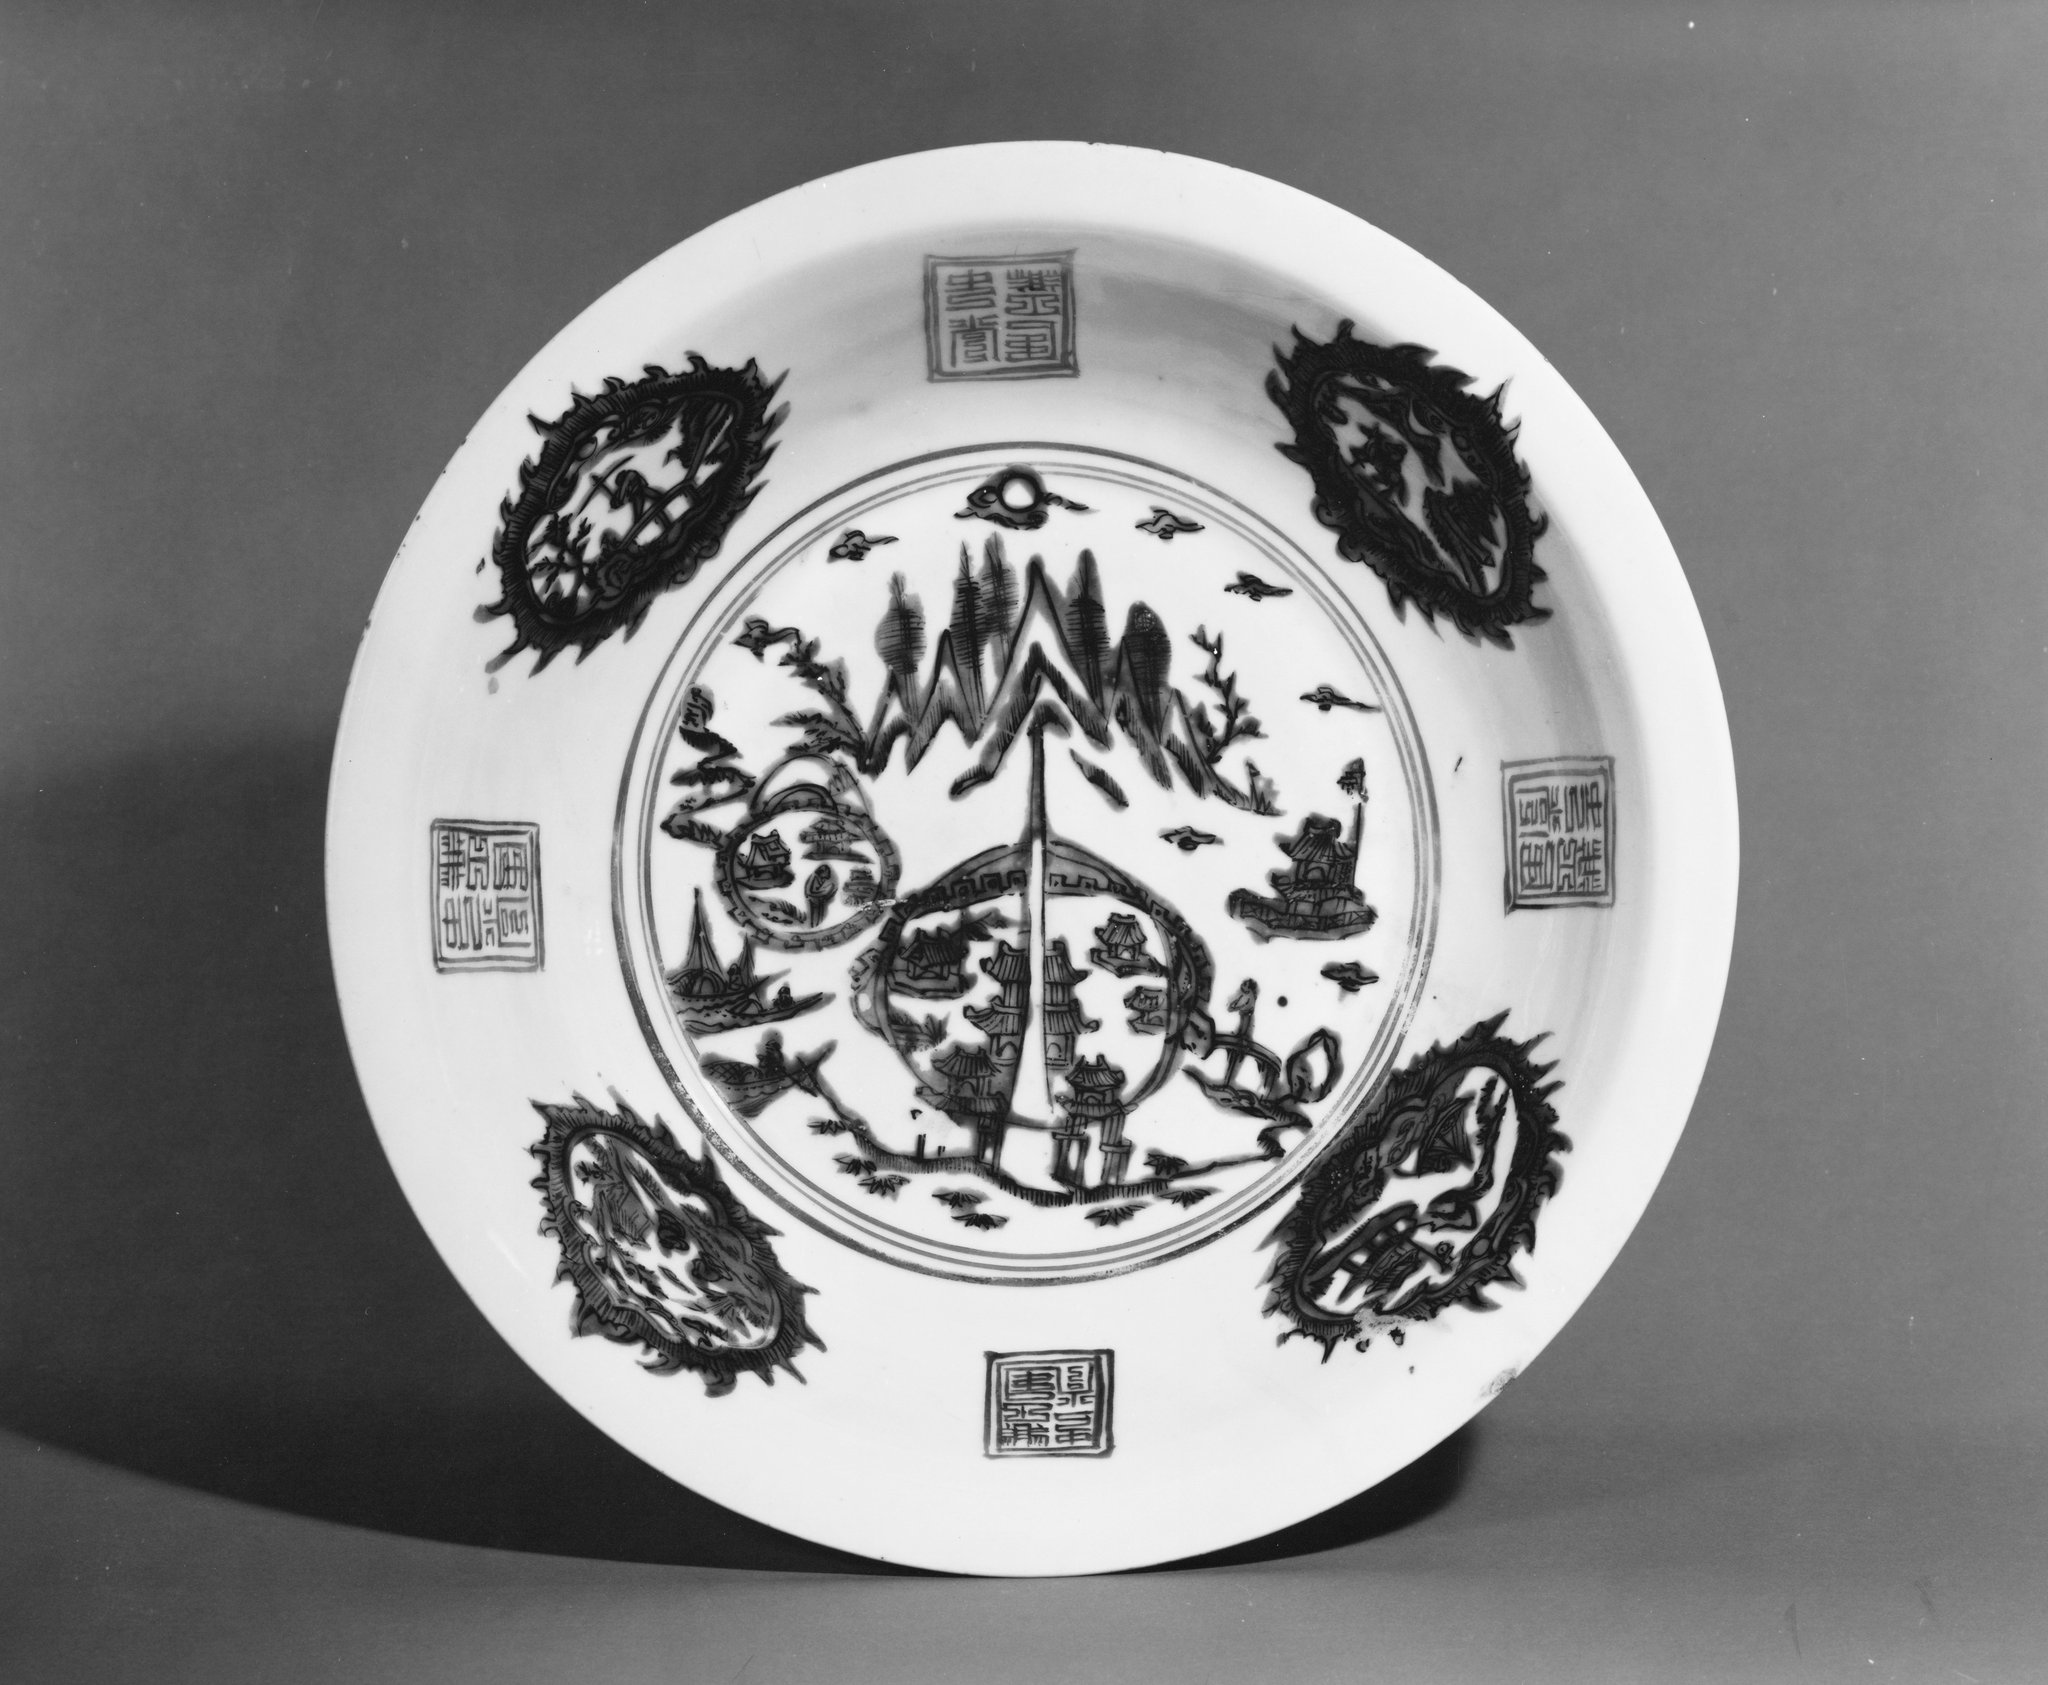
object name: plate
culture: chinese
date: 1567-1633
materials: enamel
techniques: overglaze, painting, polychrome